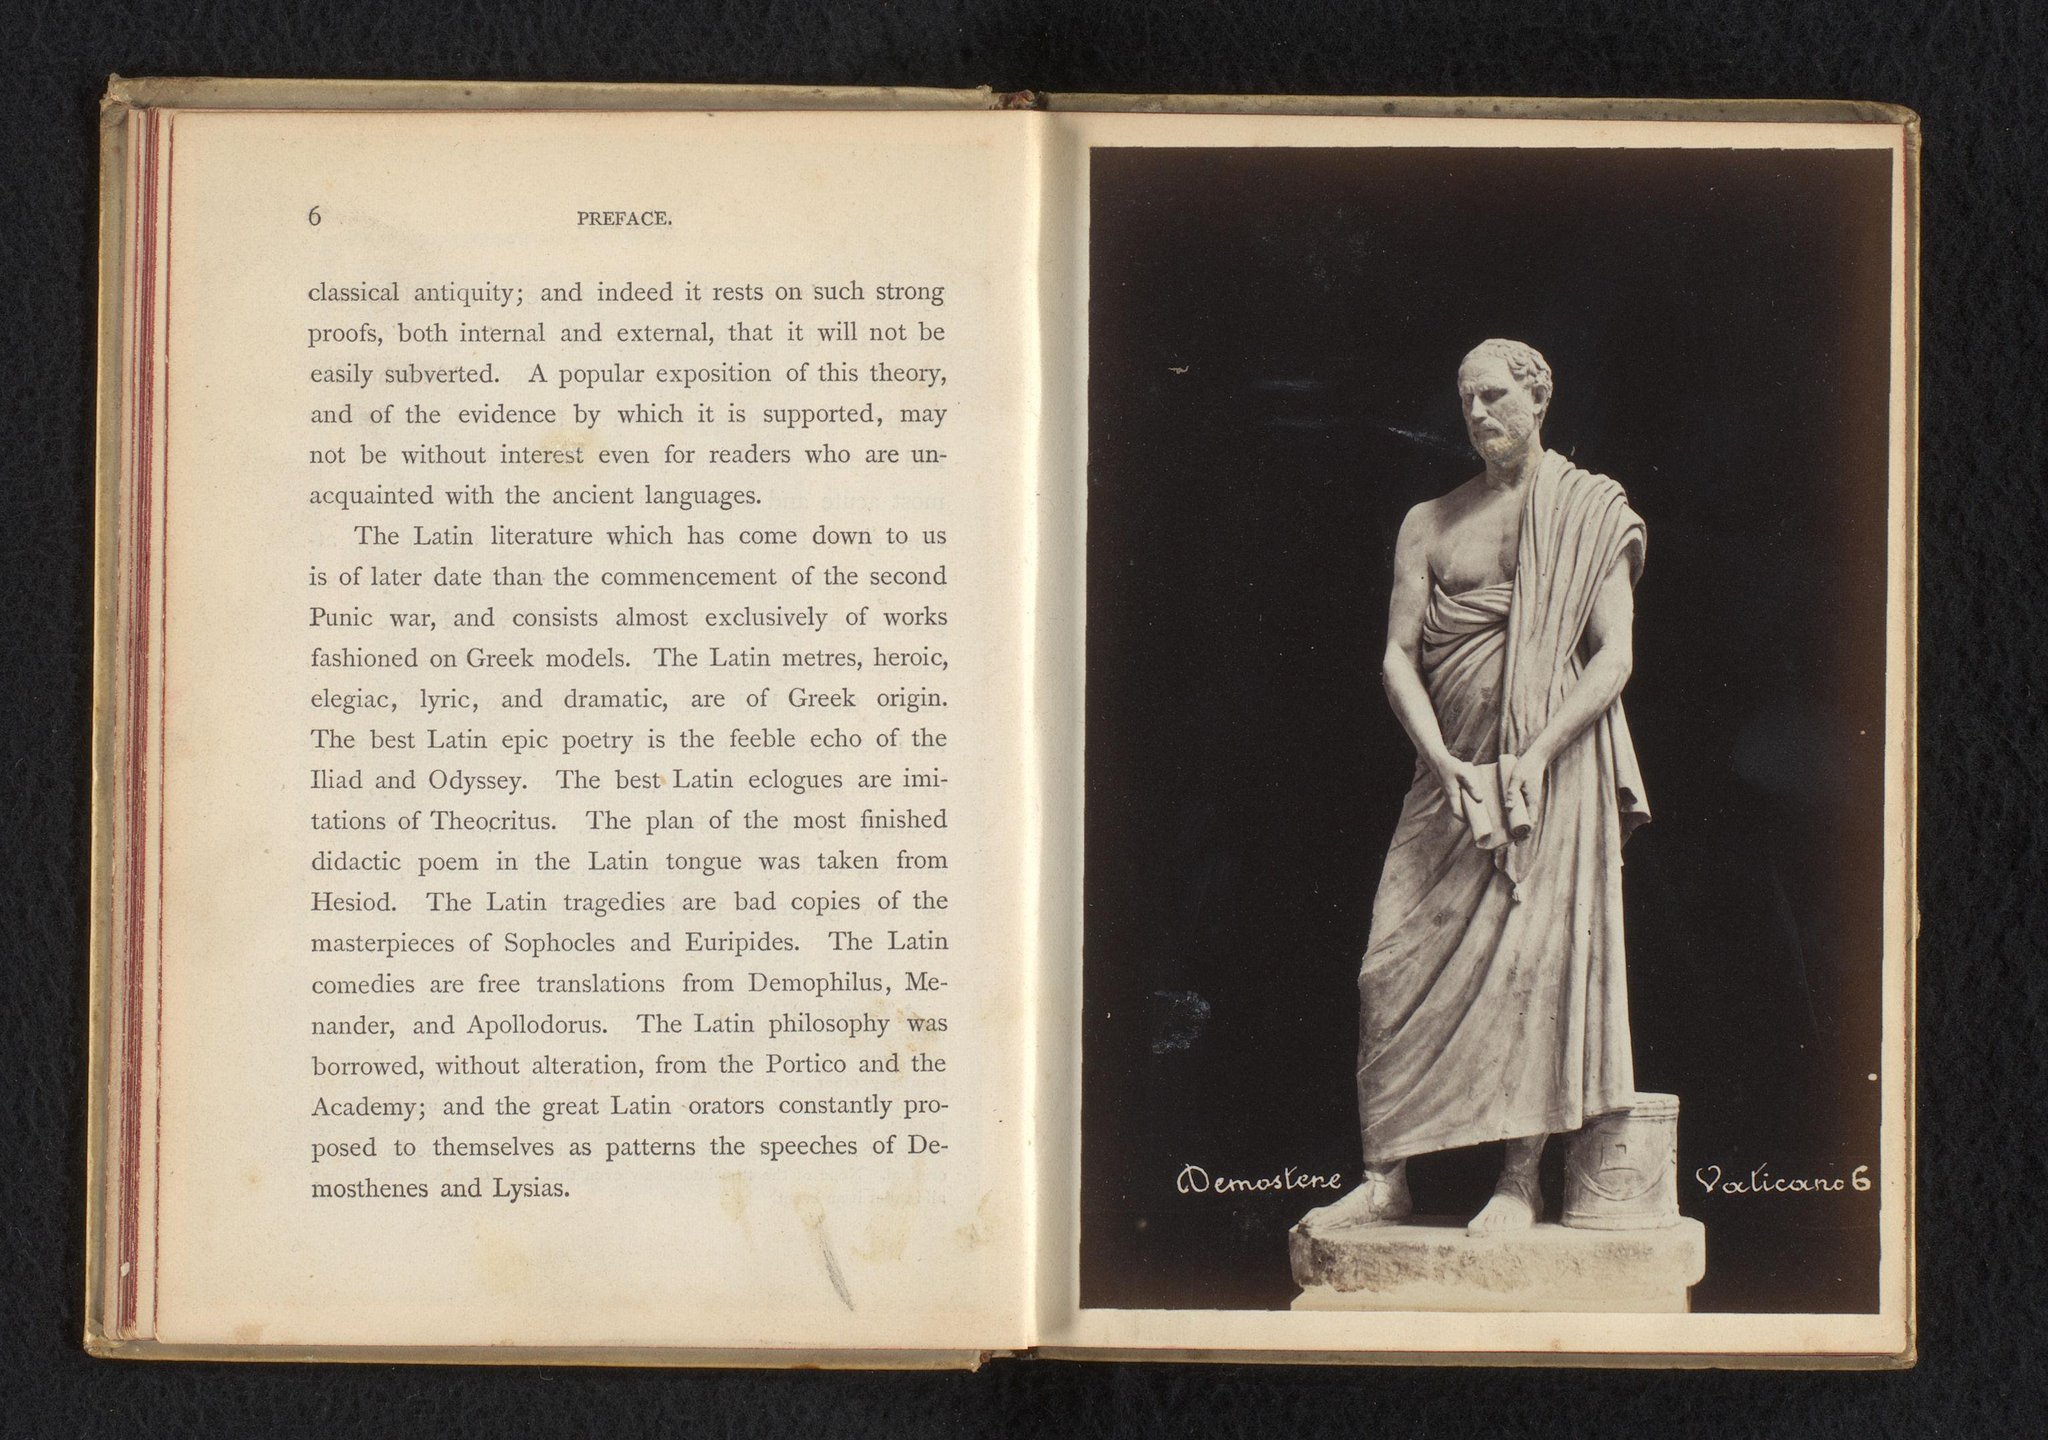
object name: page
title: Standbeeld van Demosthenes in de Vaticaanse Musea, Vaticaanstad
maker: Anonymous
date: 1851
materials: paper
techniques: albumen print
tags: politician, piece of sculpture, reproduction of a piece of sculpture, (story of) demosthenes, person addressing a group, orator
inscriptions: number: ‘6’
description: Foto op ongenummerde pagina tegenover pagina 6.